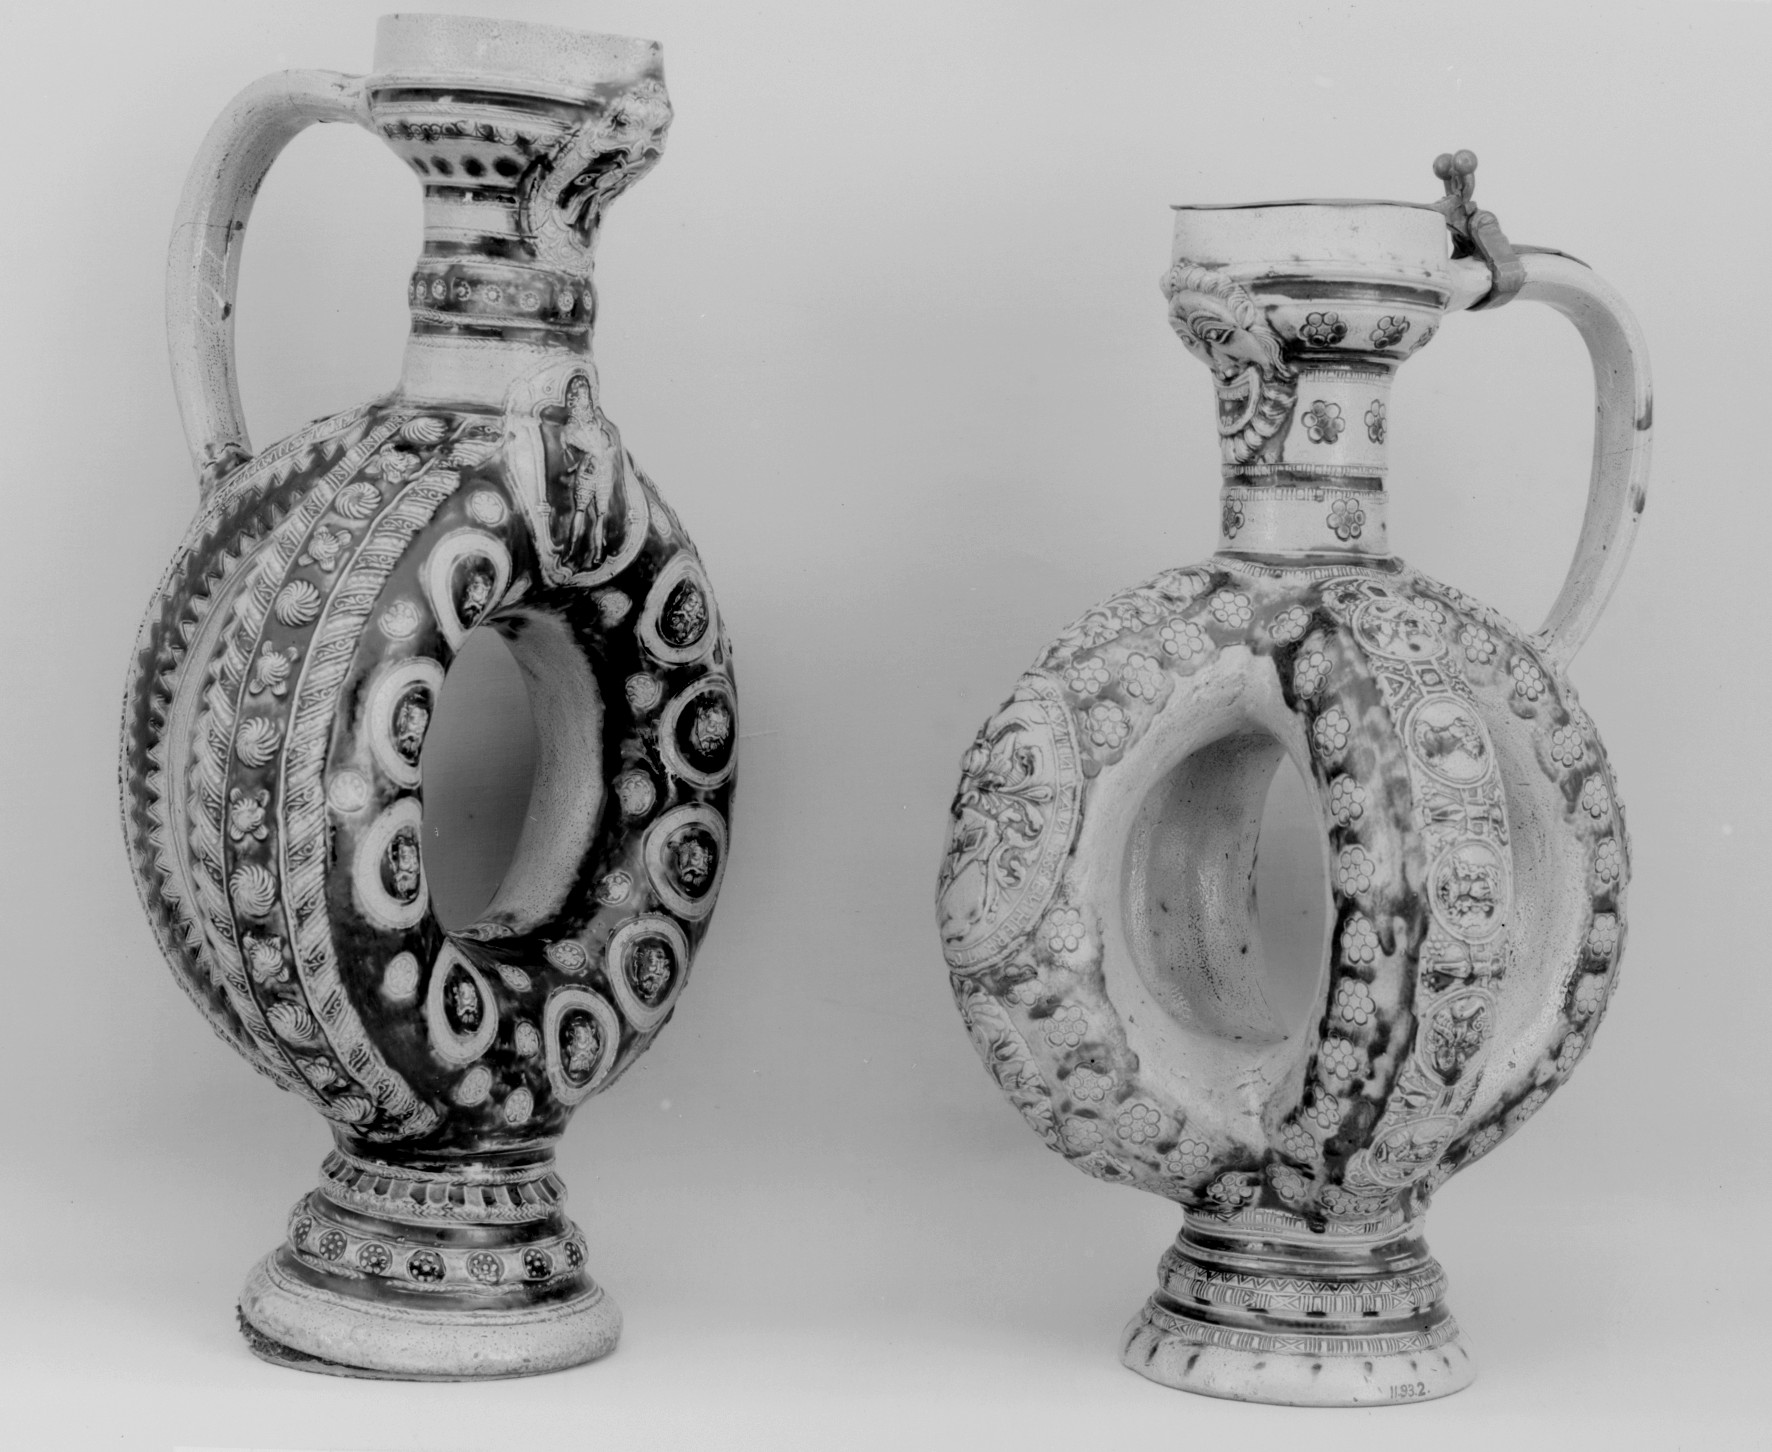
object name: jug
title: Annular jug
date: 1601-1700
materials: pewter, stoneware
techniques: salt glaze